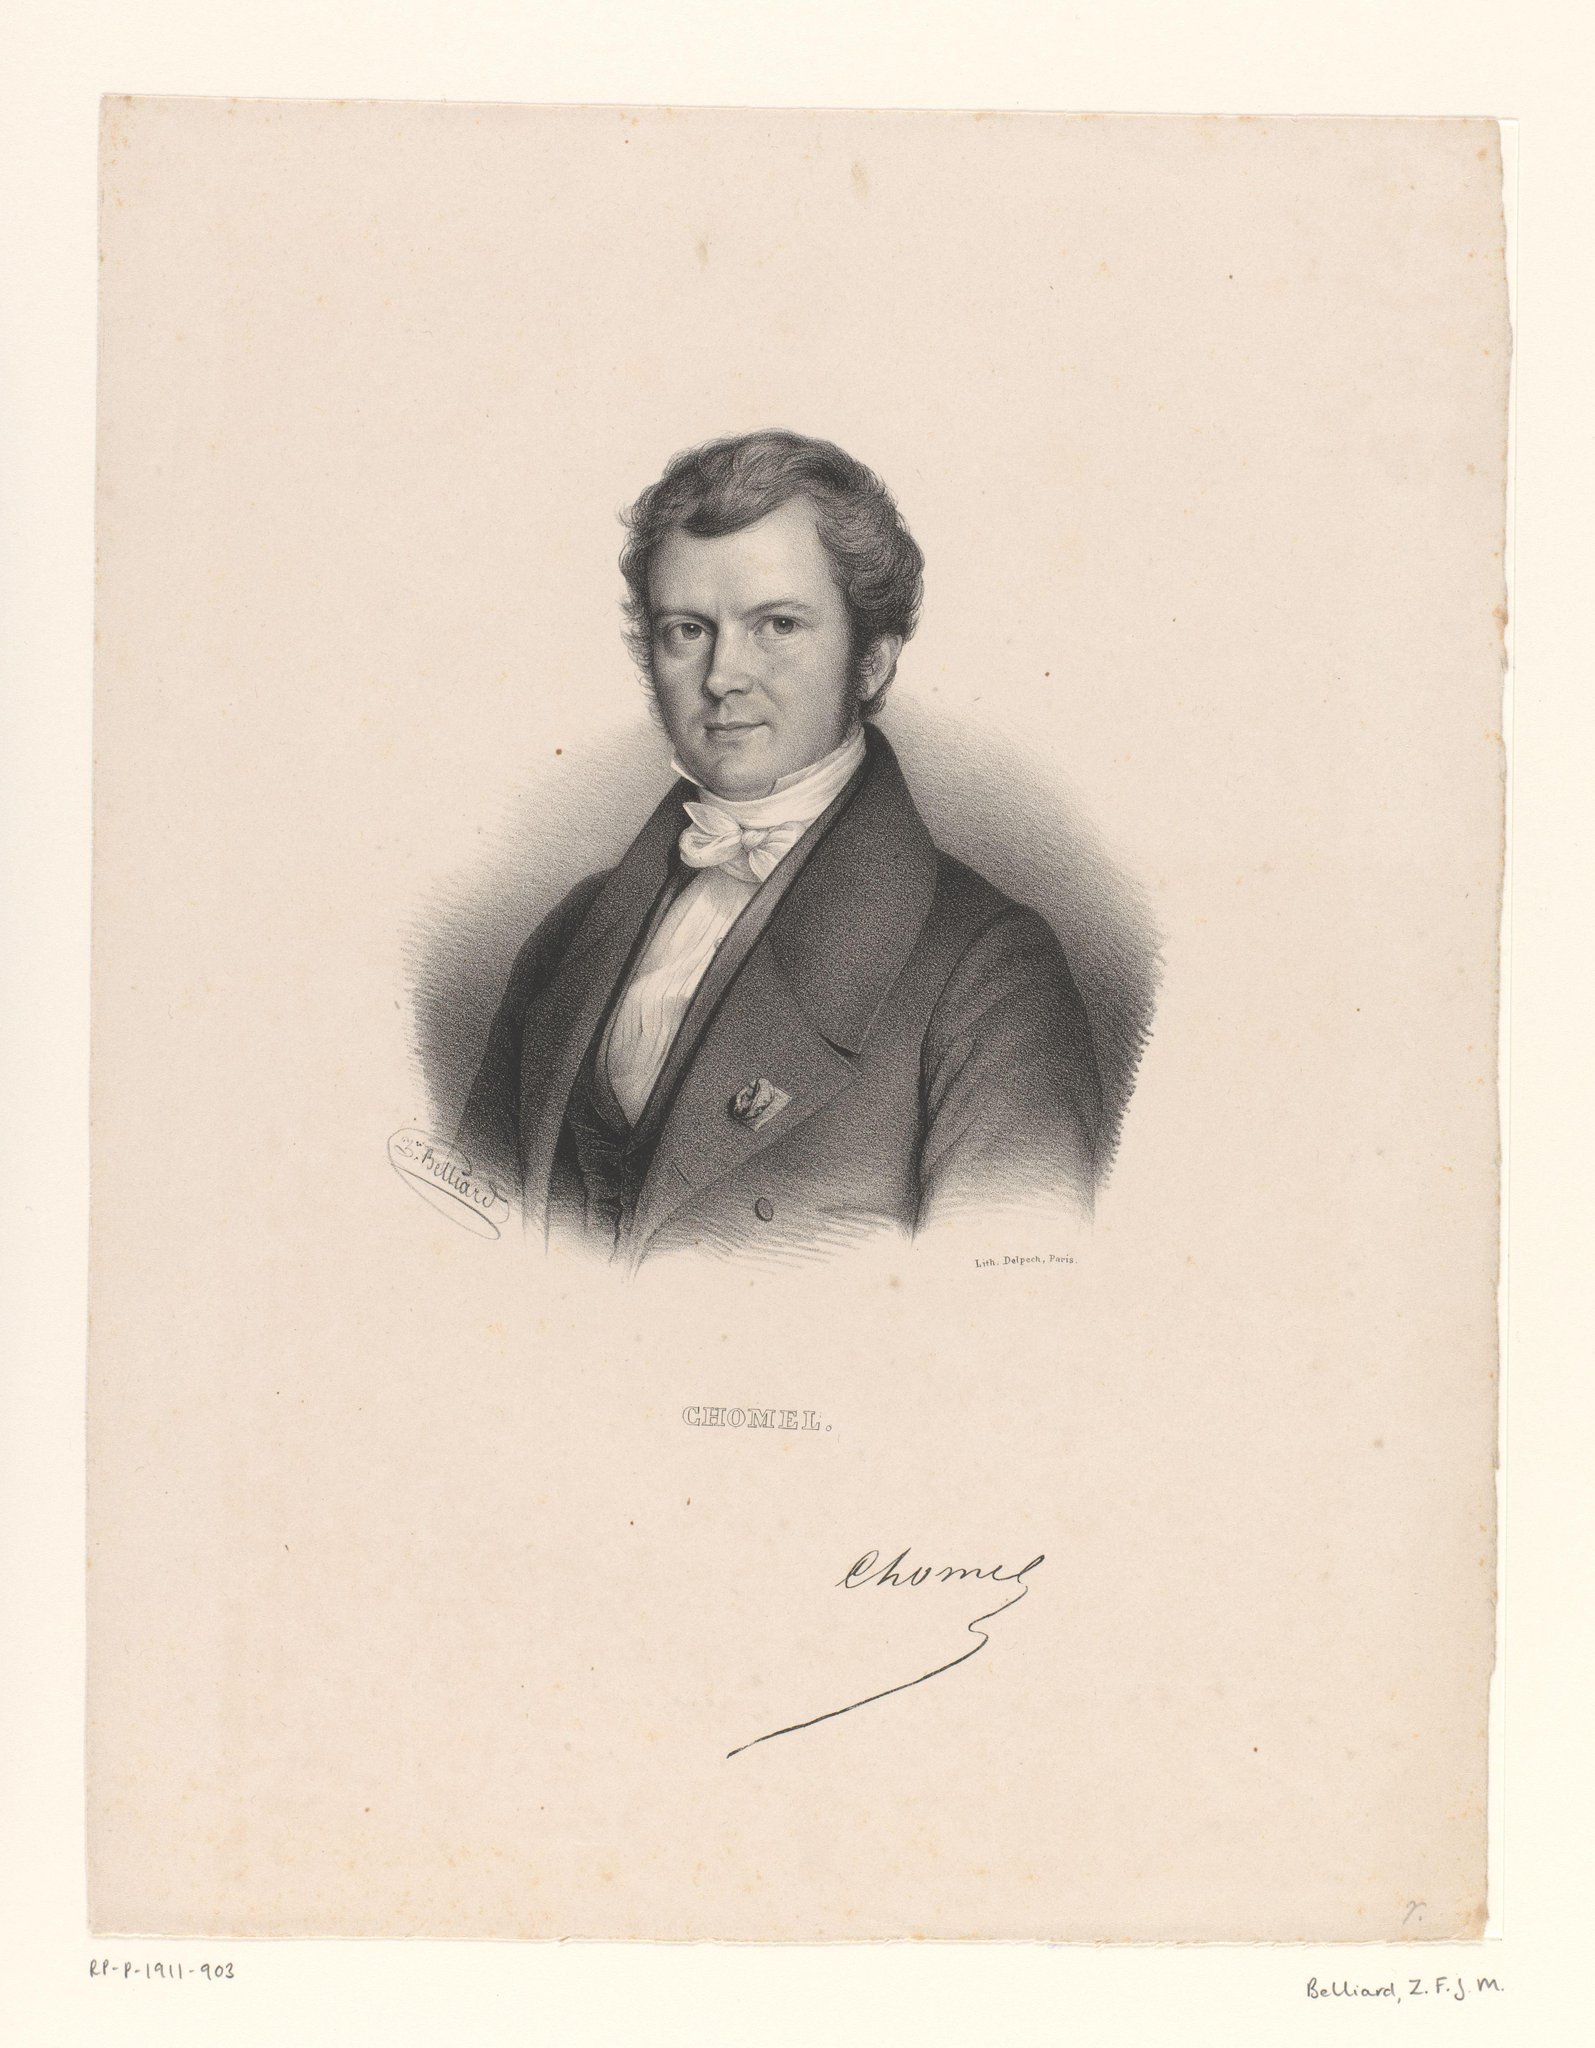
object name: print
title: Portret van de patholoog Auguste-François Chomel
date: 1837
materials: paper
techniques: lithograph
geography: paris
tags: paris, historical persons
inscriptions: collector's mark: Lugt 2228a